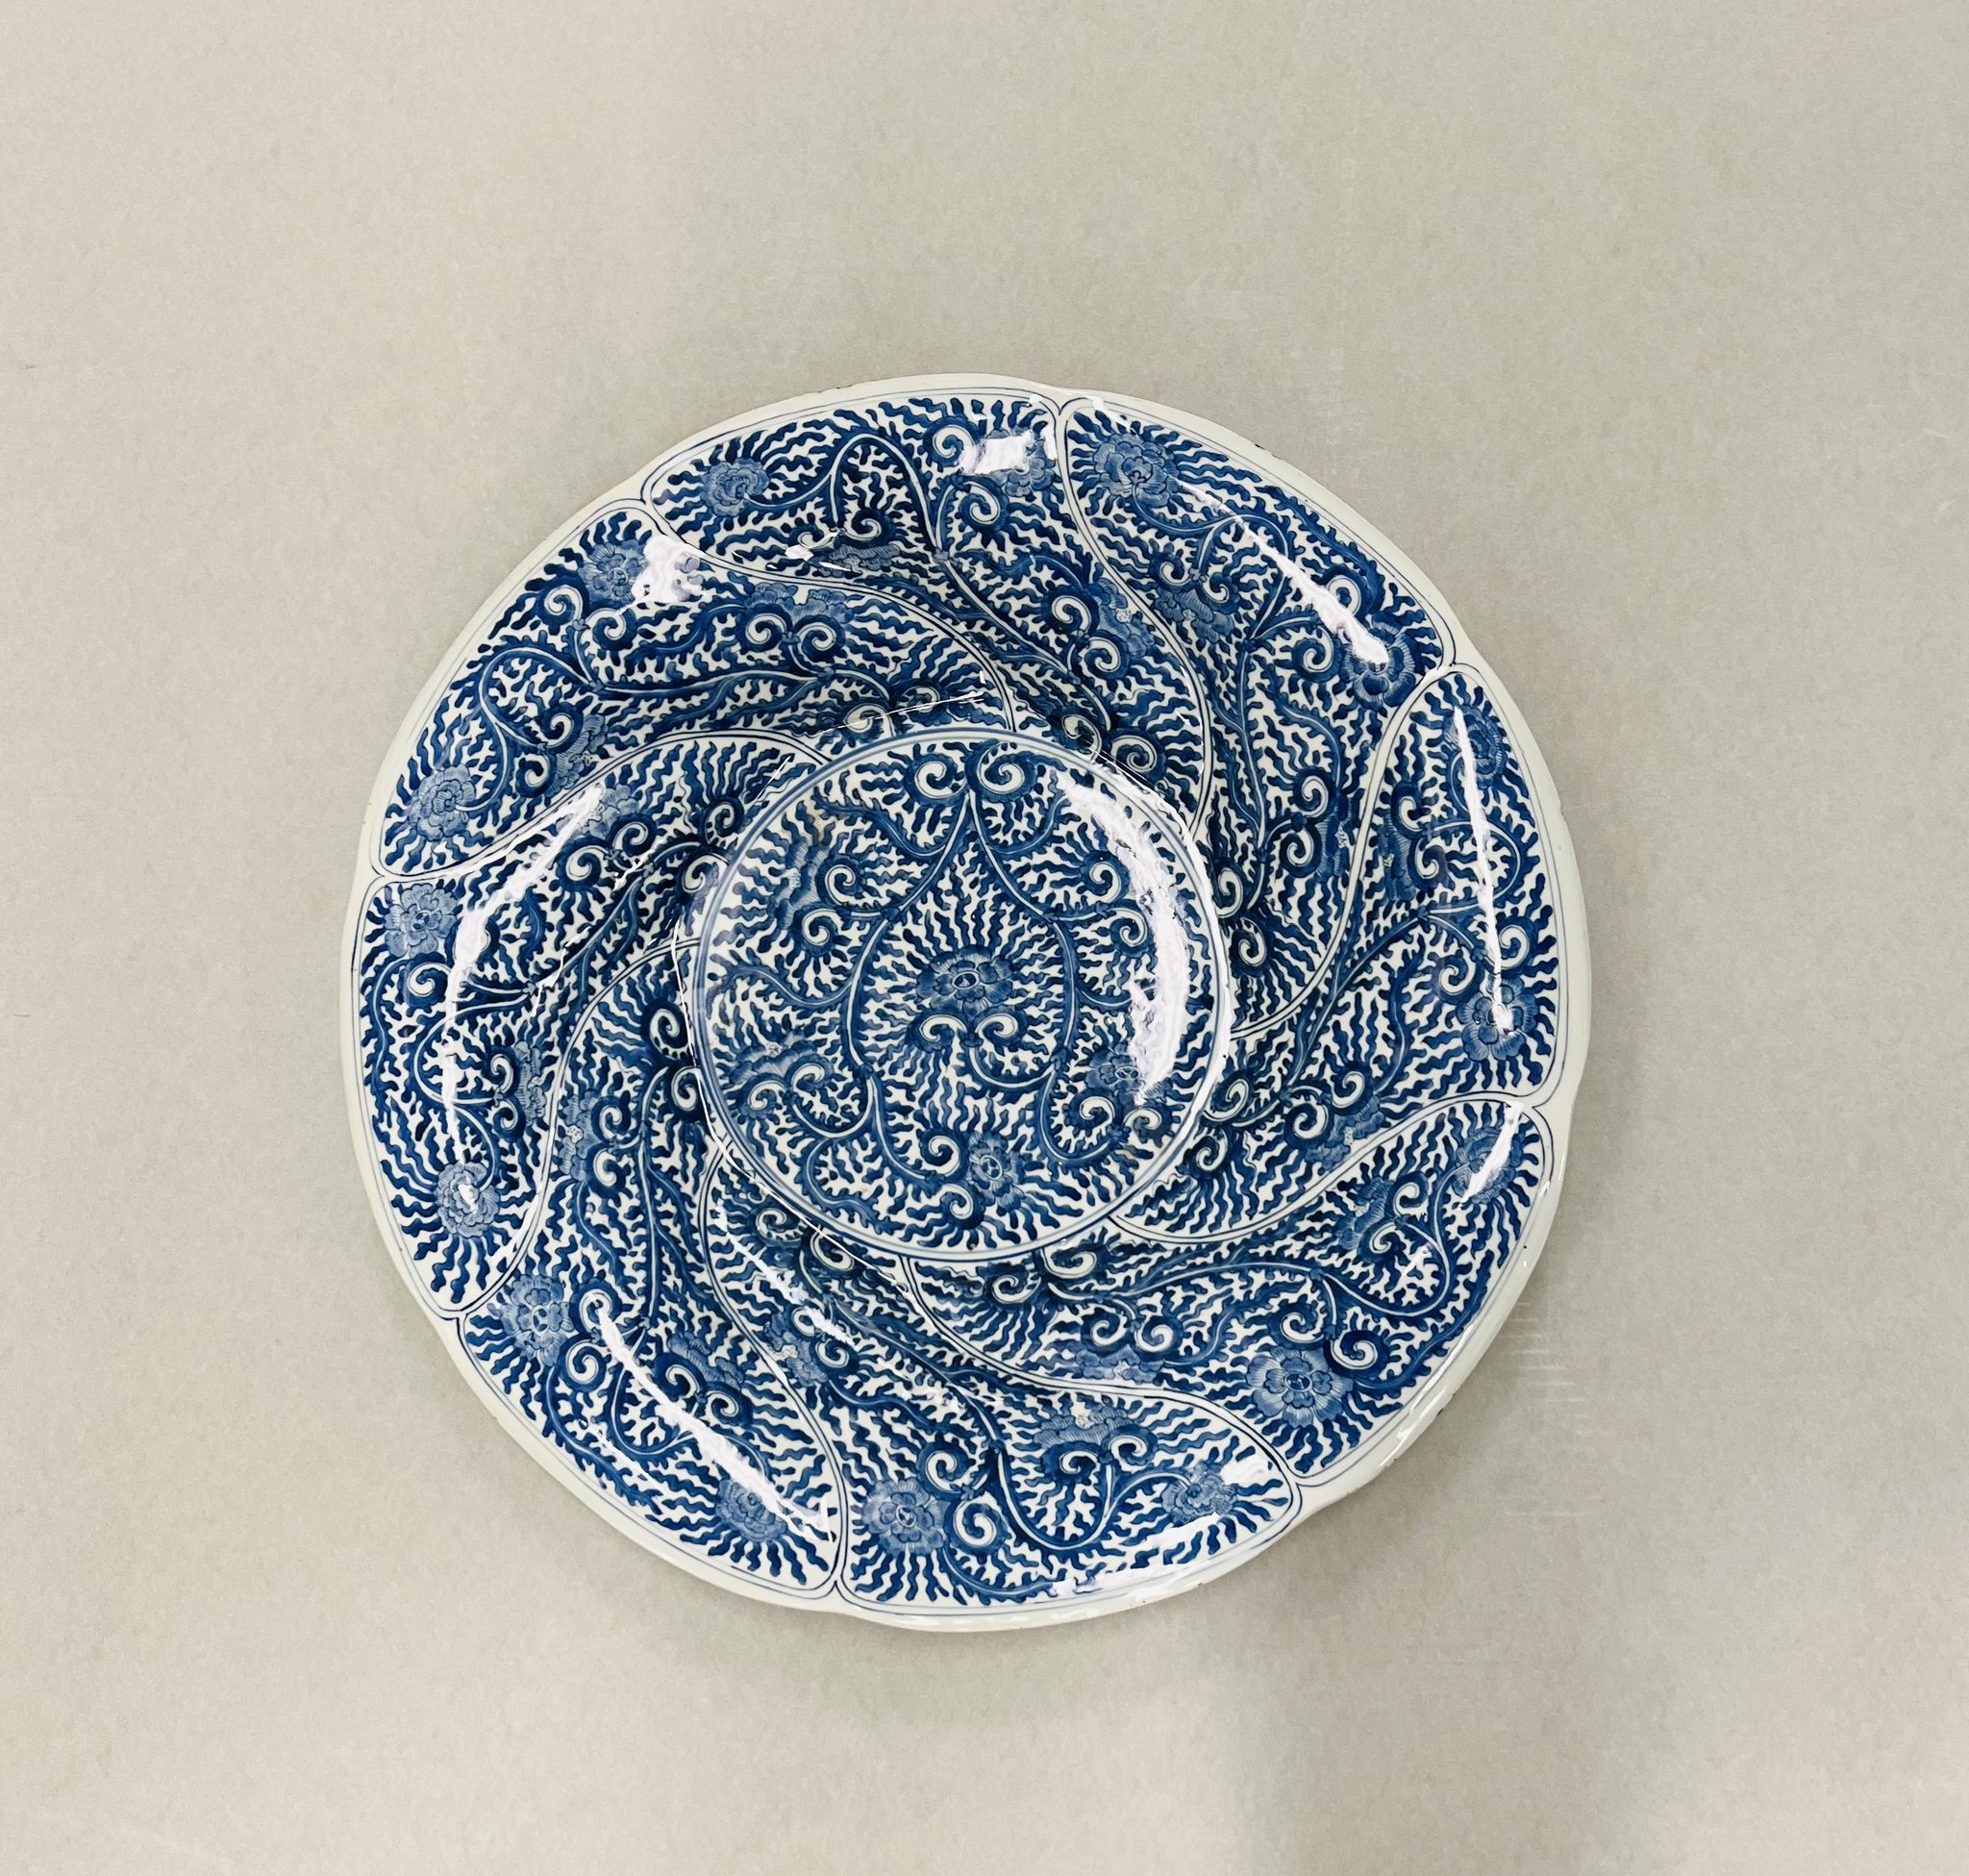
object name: plate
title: Plate with scalloped rim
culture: chinese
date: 1667-1733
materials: cobalt, porcelain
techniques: painting, underglaze